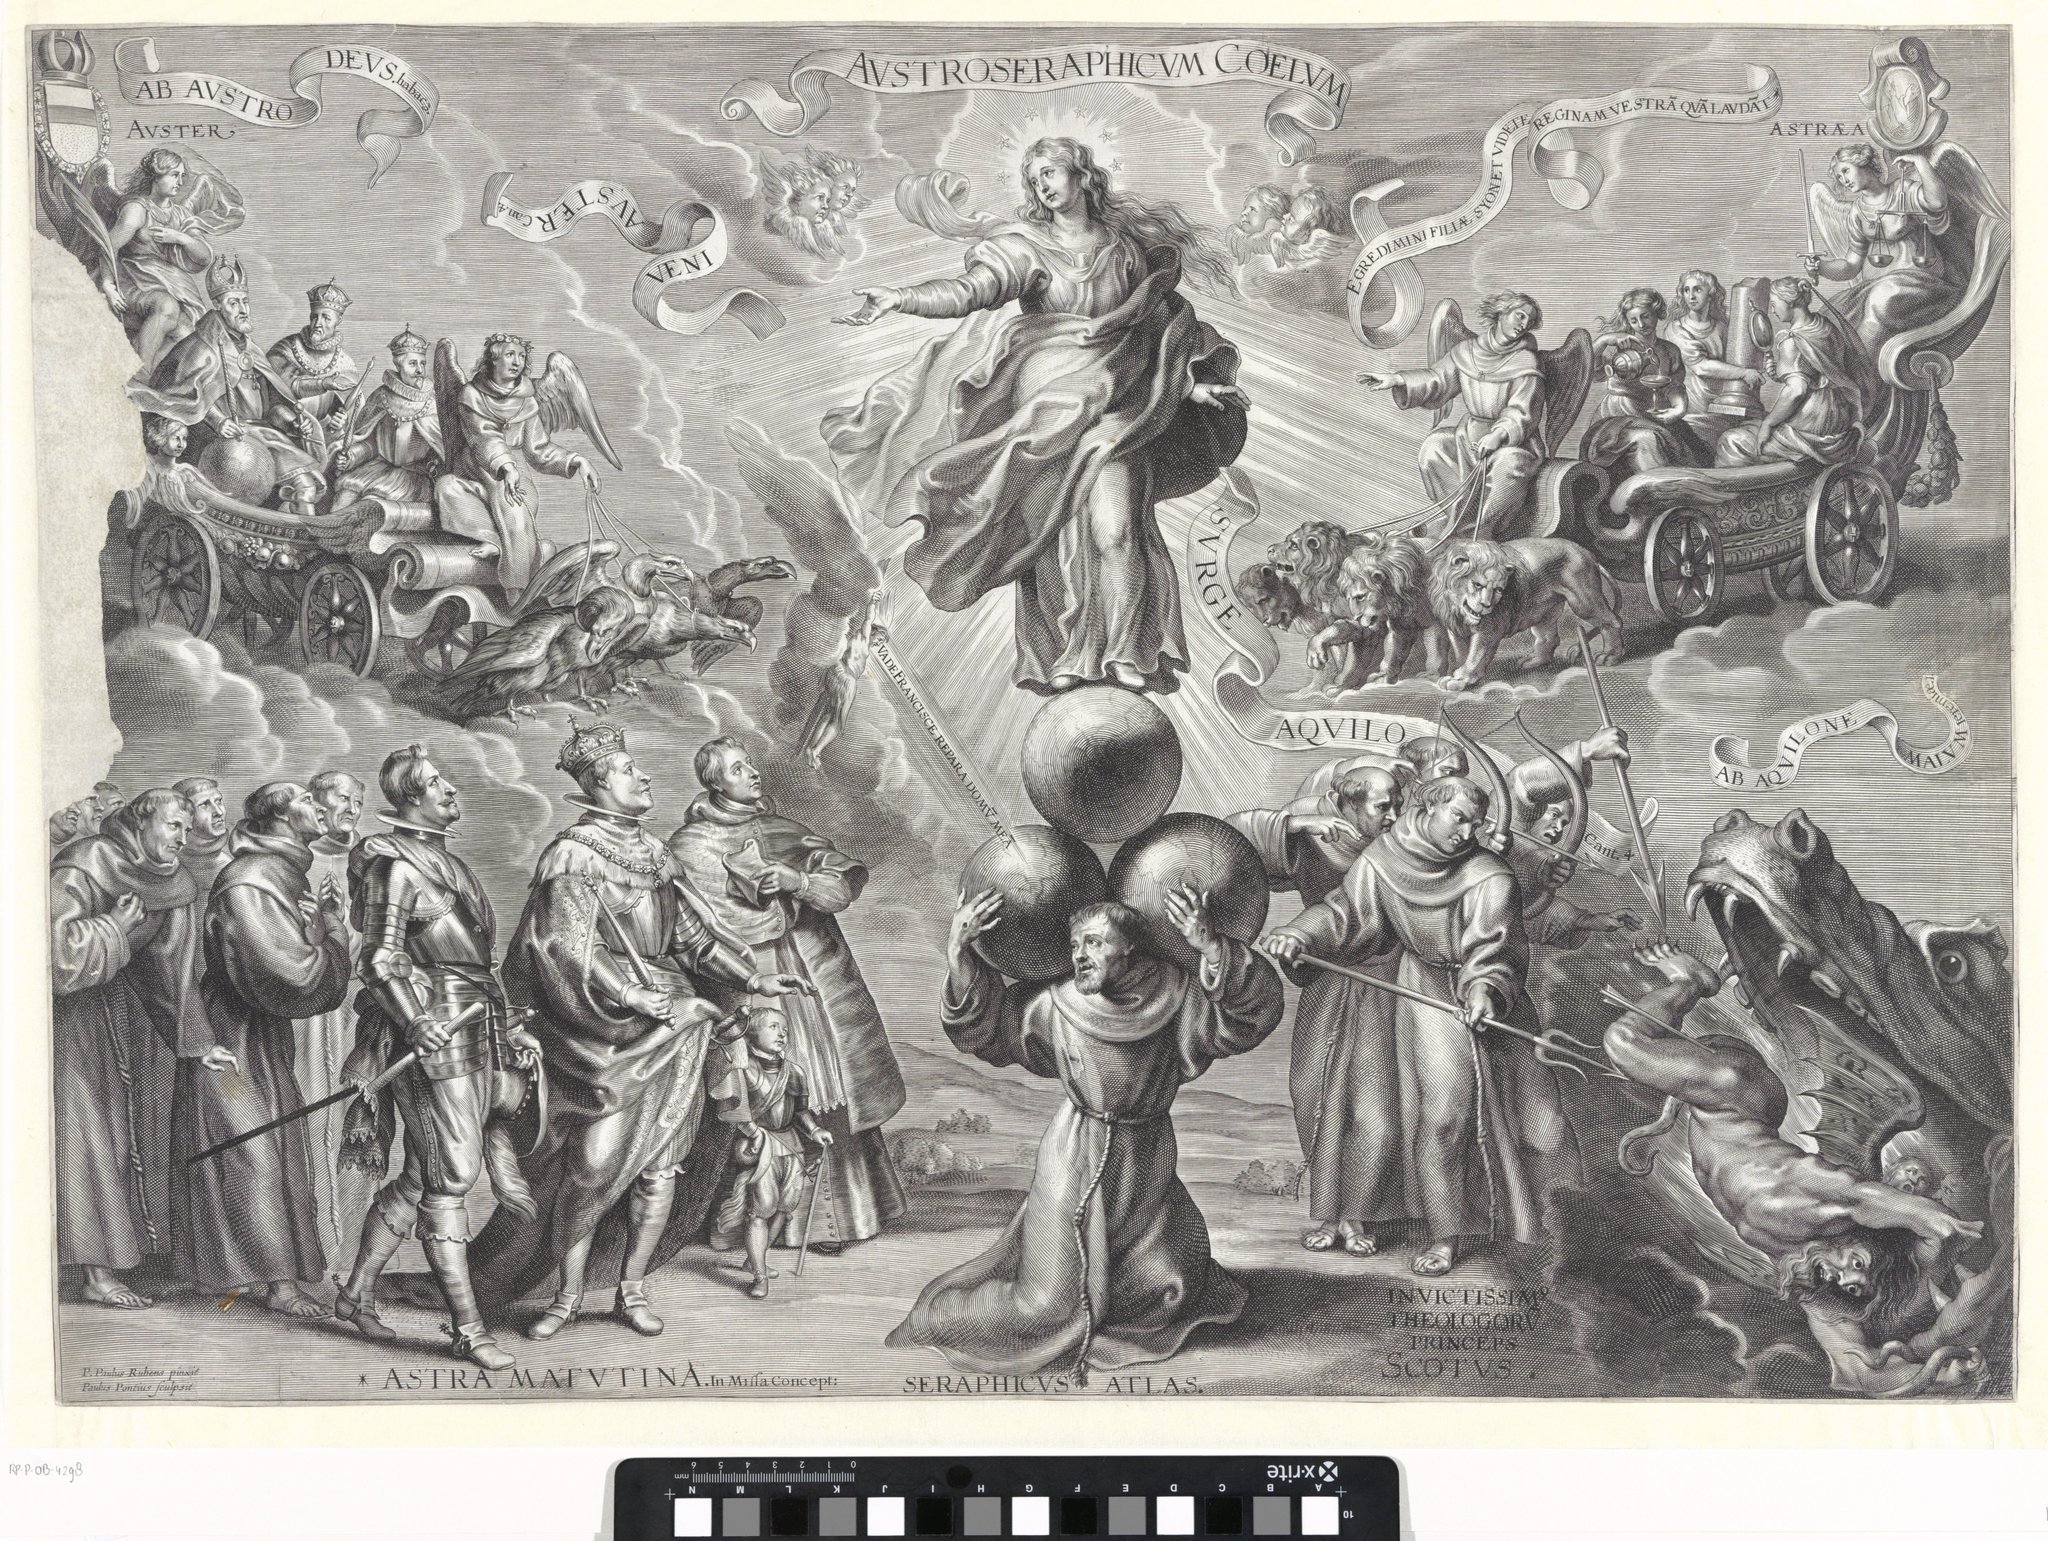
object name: print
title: Promotieprent met H. Franciscus met drie globes op de schouders, bovenste deel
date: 1616-1657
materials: paper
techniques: engraving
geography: antwerp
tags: filips iv (koning van spanje), devil(s) and demons, monk(s), friar(s), founder of the order of friars minor (franciscans), francis(cus) of assisi; possible attributes: book, crucifix, lily, skull, stigmata, the four cardinal virtues, mary standing or resting on the earth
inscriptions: collector's mark: Lugt 2228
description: De heilige Franciscus ('Seraphicus Atlas') zit geknield in een landschap, drie globes rusten op zijn schouders. Op één daarvan staat Maria. Links Filips IV, koning van Spanje, vergezeld door familieleden. Ze kijken op naar Maria. Rechts verdrijven monniken duivels. In de lucht twee wagens voortgetrokken door adelaars en leeuwen, in de één Habsburgse koningen (links), in de ander personificaties van de kardinale deugden.